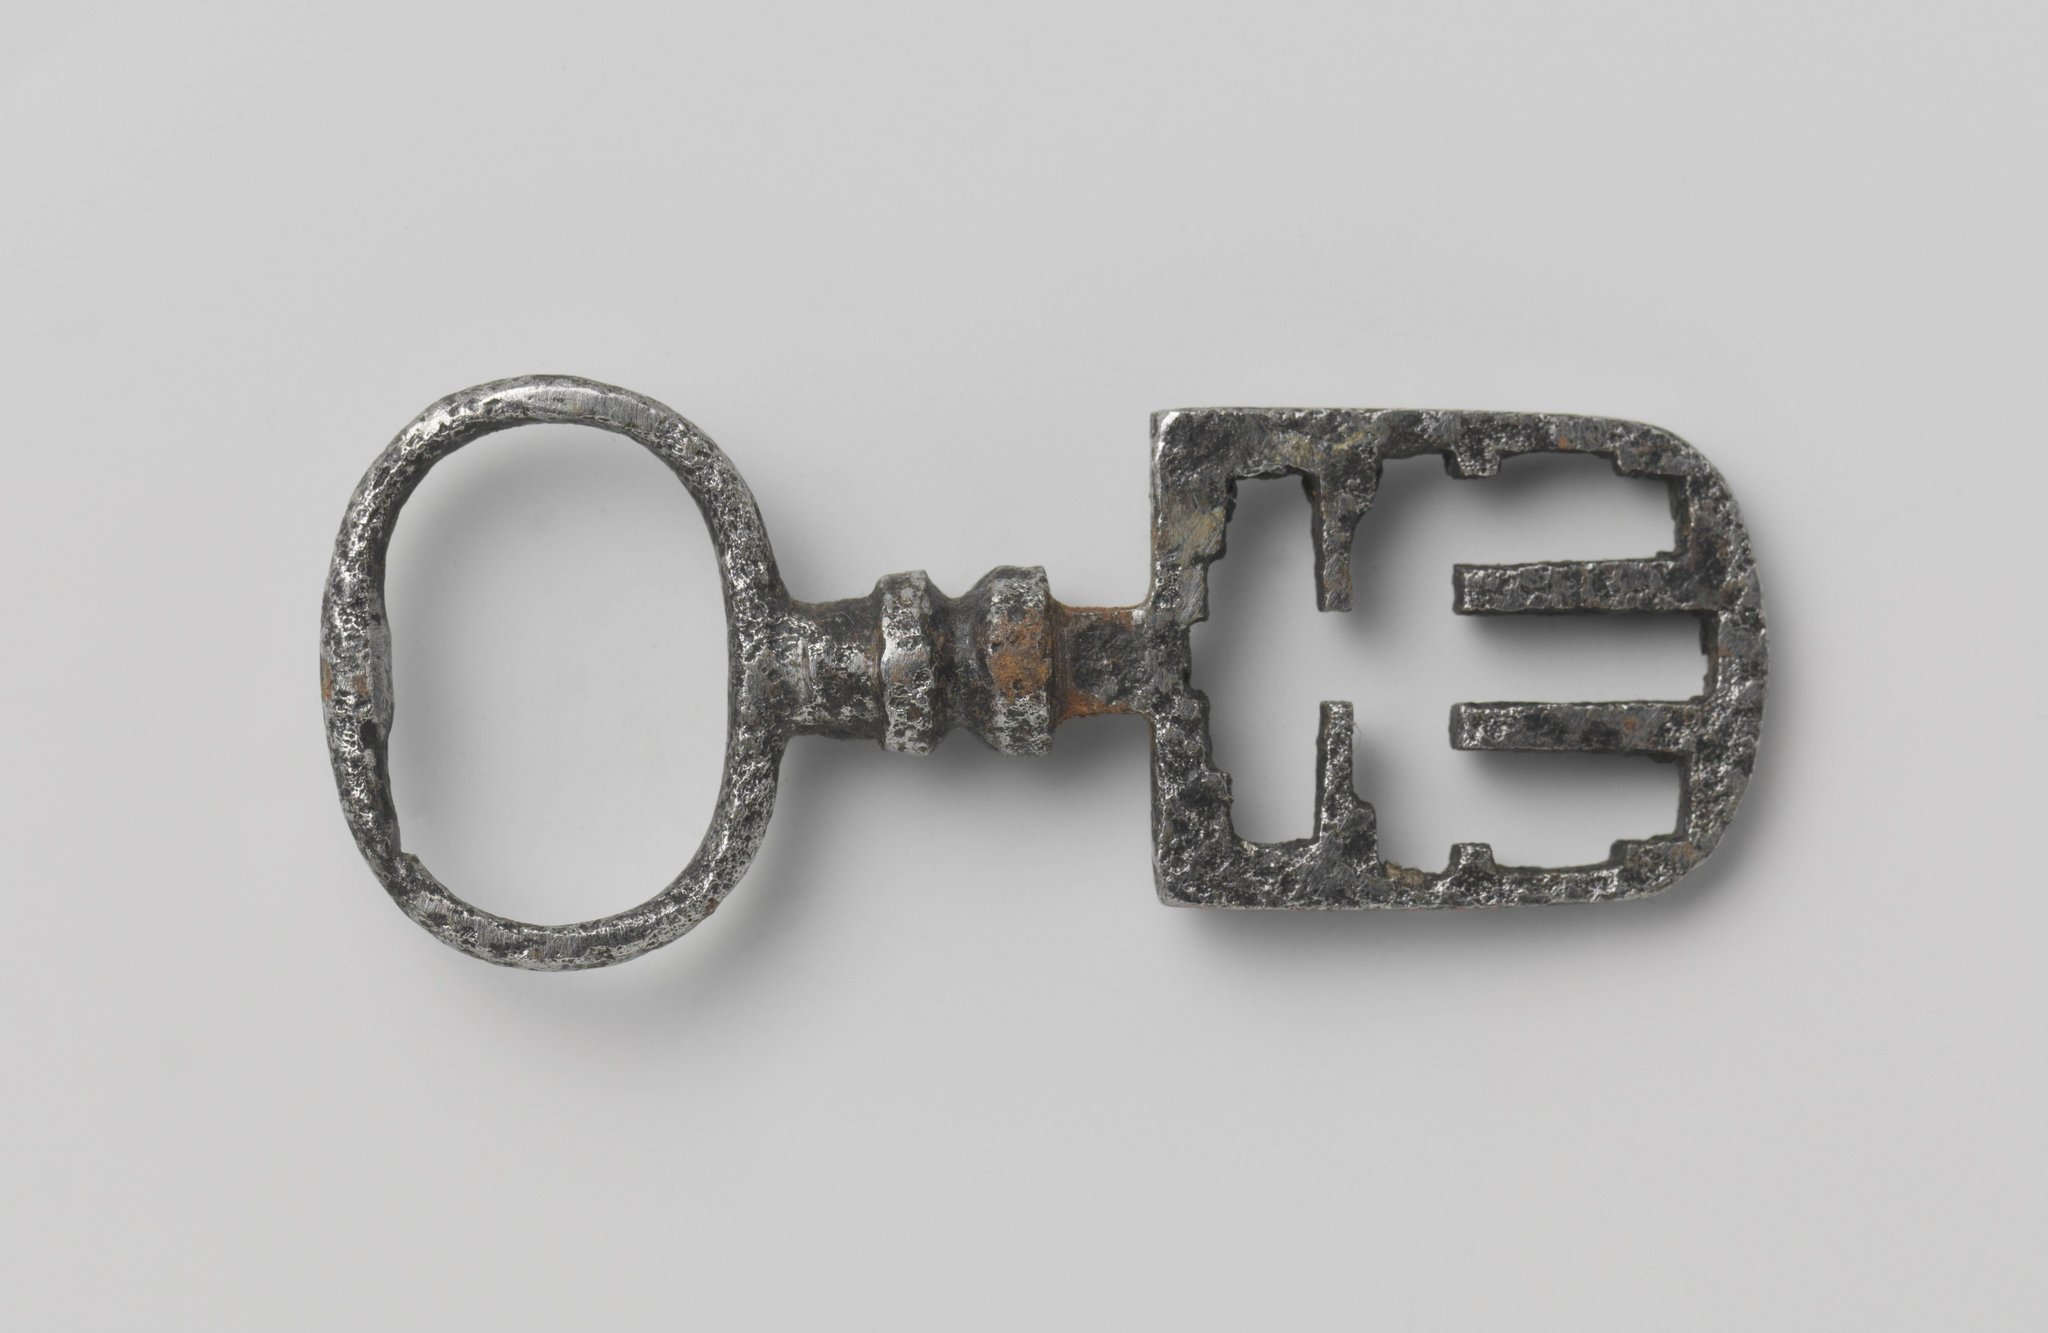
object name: schuifsleutel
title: Key latch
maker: Anonymous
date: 1800-1900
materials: iron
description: Schuifsleutel met ovaal oog, zeer korte schacht, geprofileerde sleutelborst en schildvormige baard.